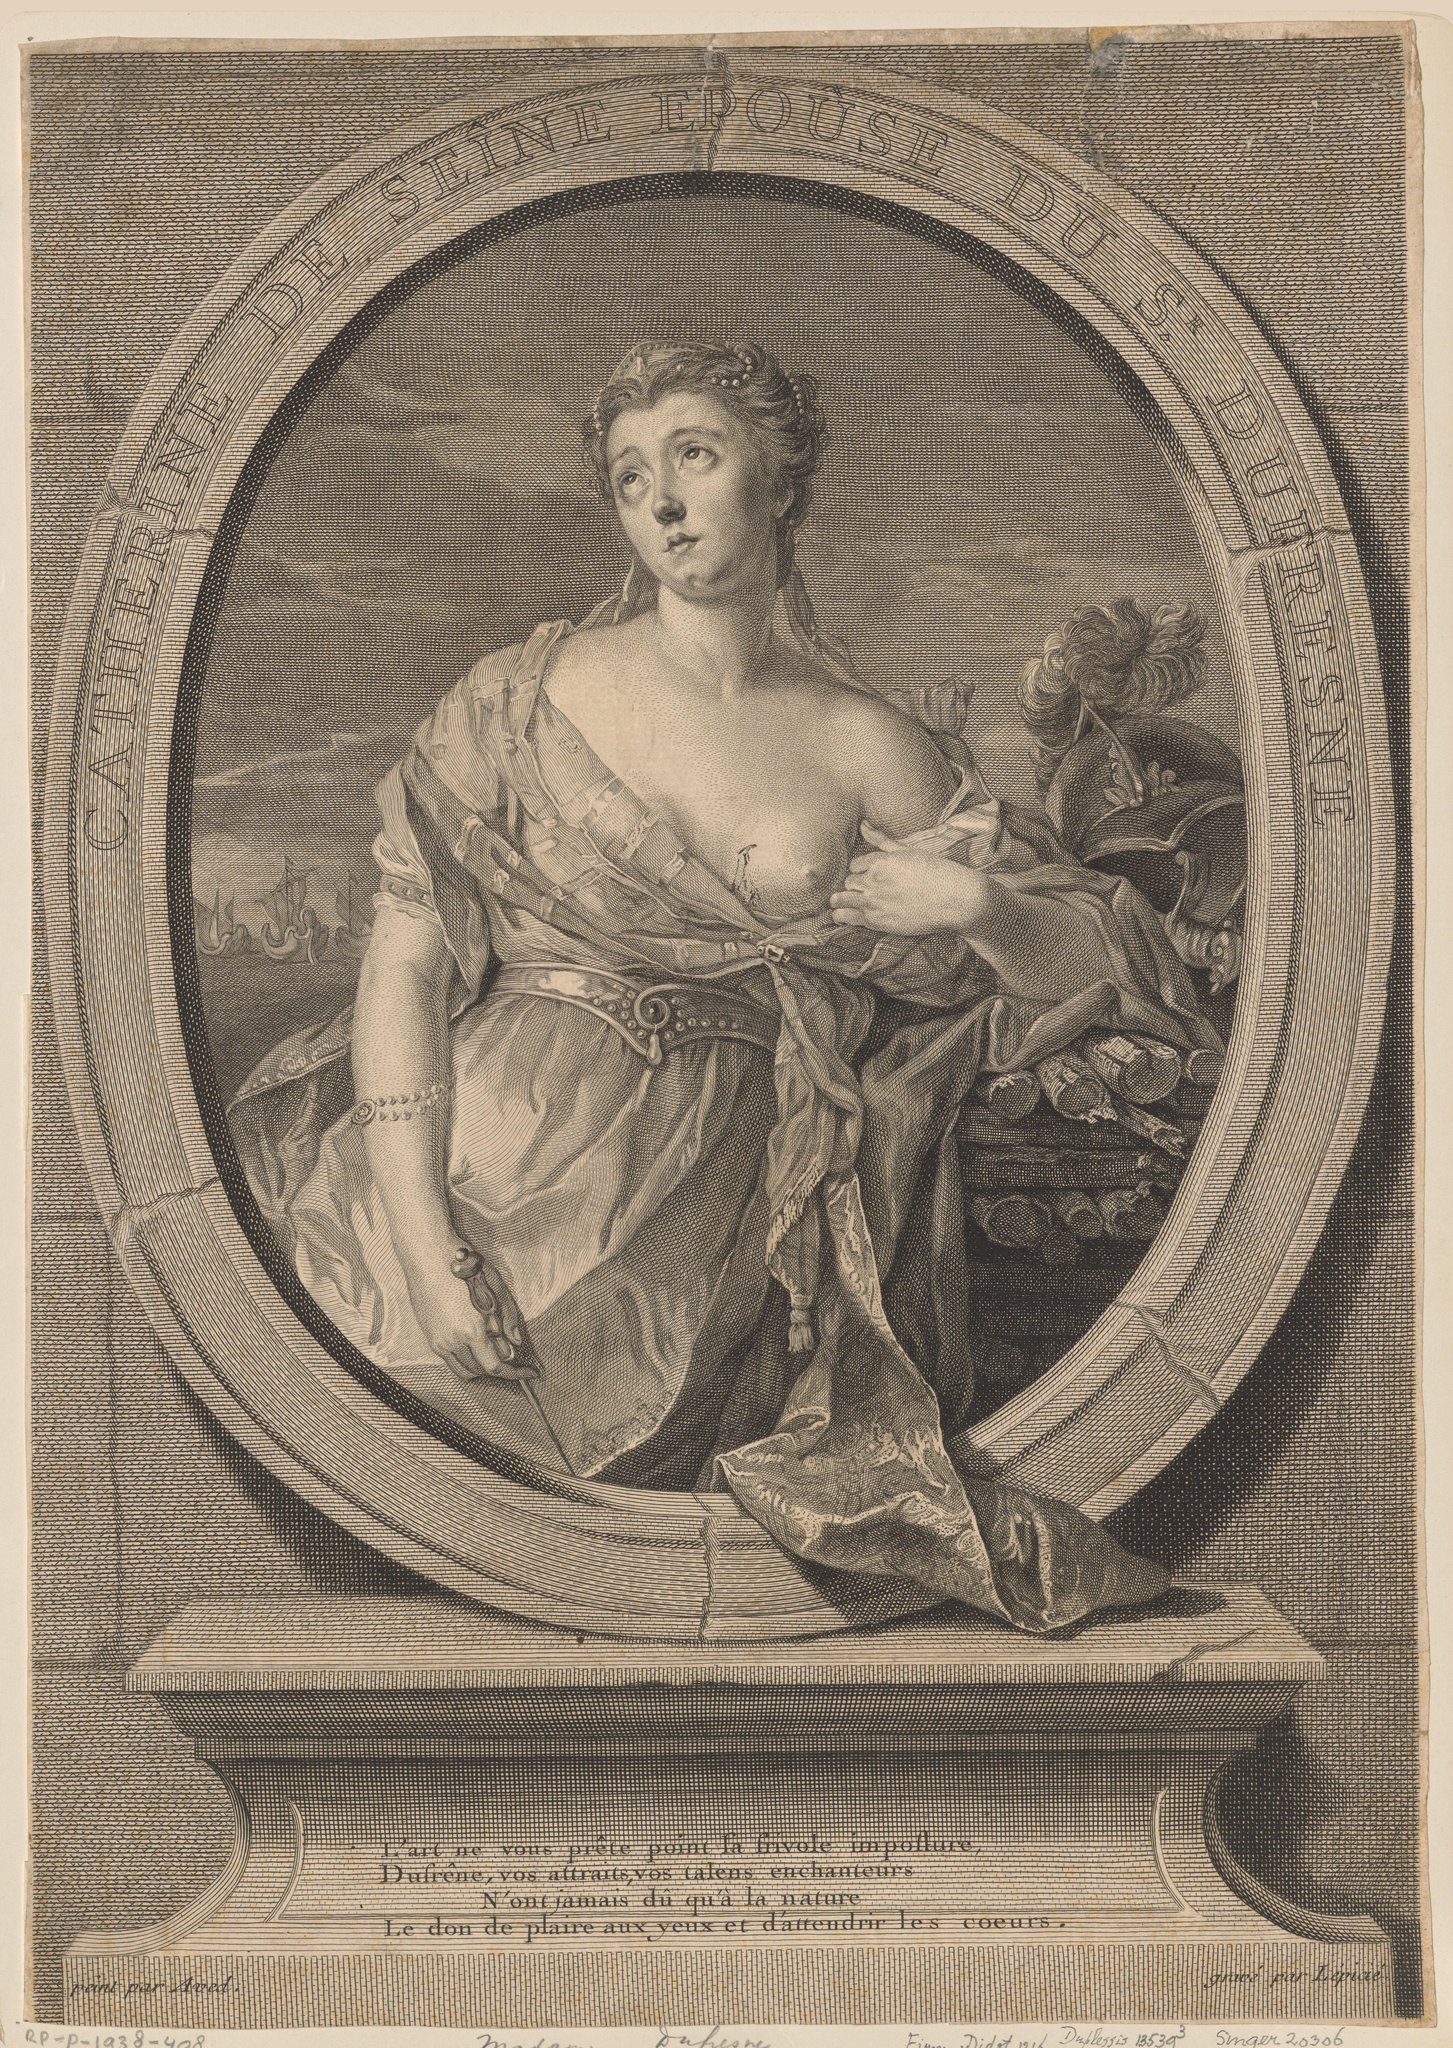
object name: print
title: Portret van Catherine-Marie-Jeanne Quinault-Dufresne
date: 1734-1735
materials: paper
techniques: engraving, etching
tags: paris, historical persons - bb - woman, portrait of actor, actress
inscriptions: collector's mark: Lugt 2228